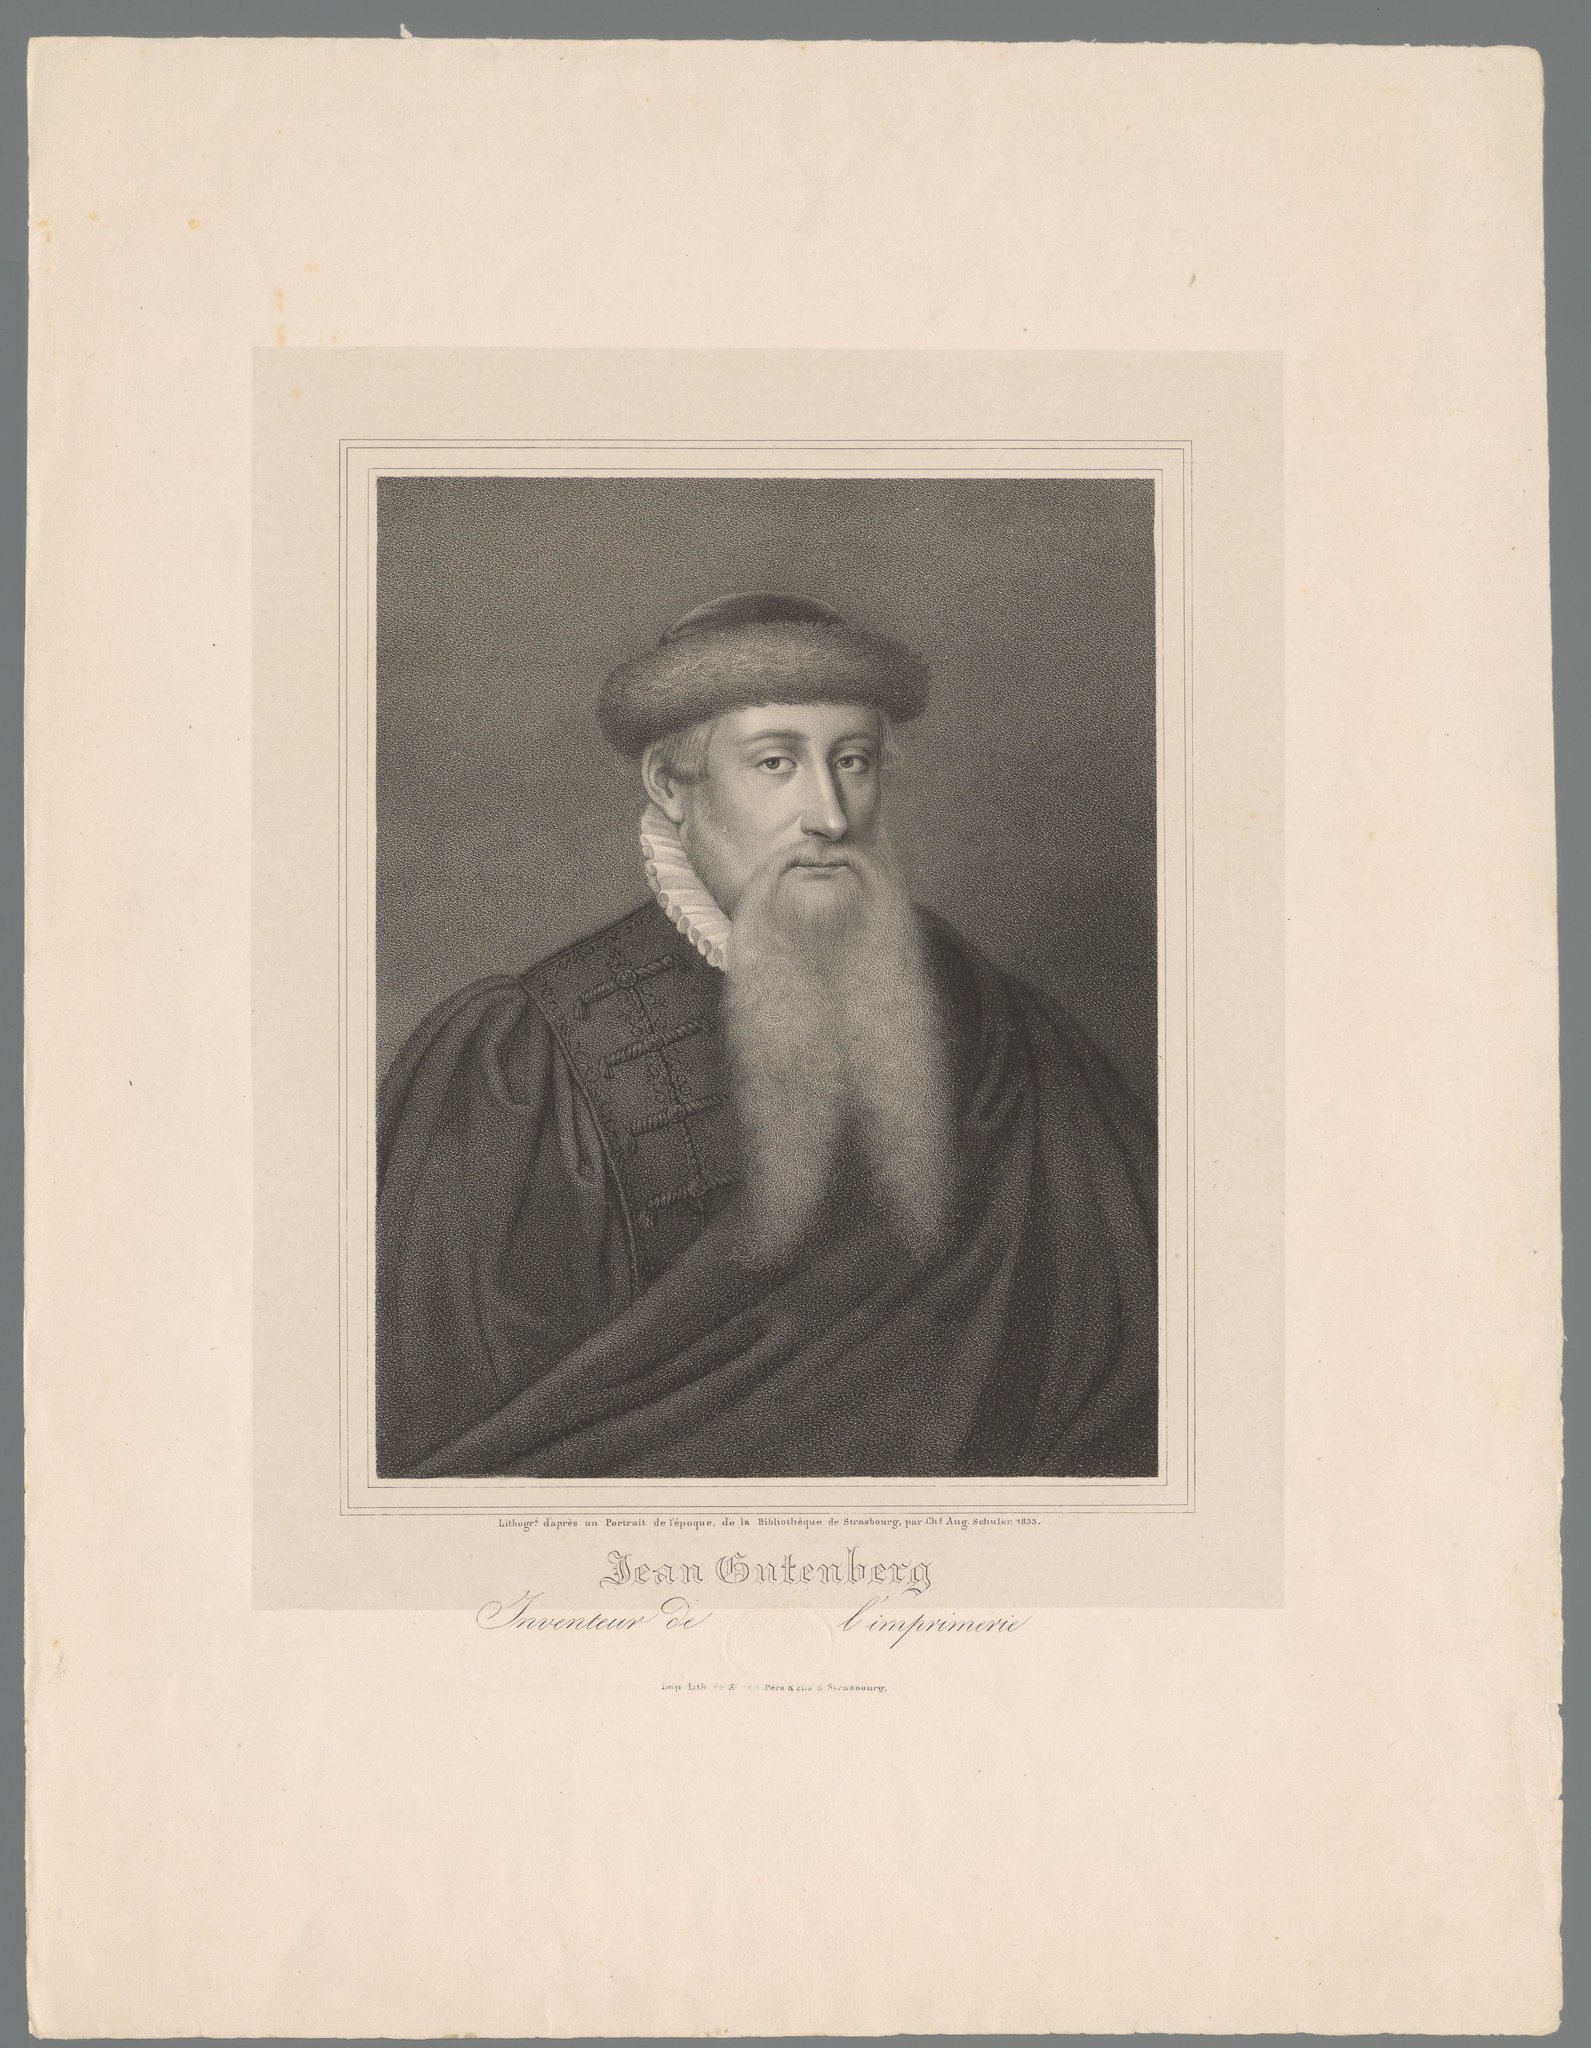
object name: print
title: Portret van Johannes Gutenberg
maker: charles auguste schuler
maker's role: print maker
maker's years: 1804-1859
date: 1833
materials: paper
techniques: lithograph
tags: printer, johannes gutenberg, historical persons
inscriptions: collector's mark: Lugt 2228, check stamp: ‘Société des Amis des Arts’